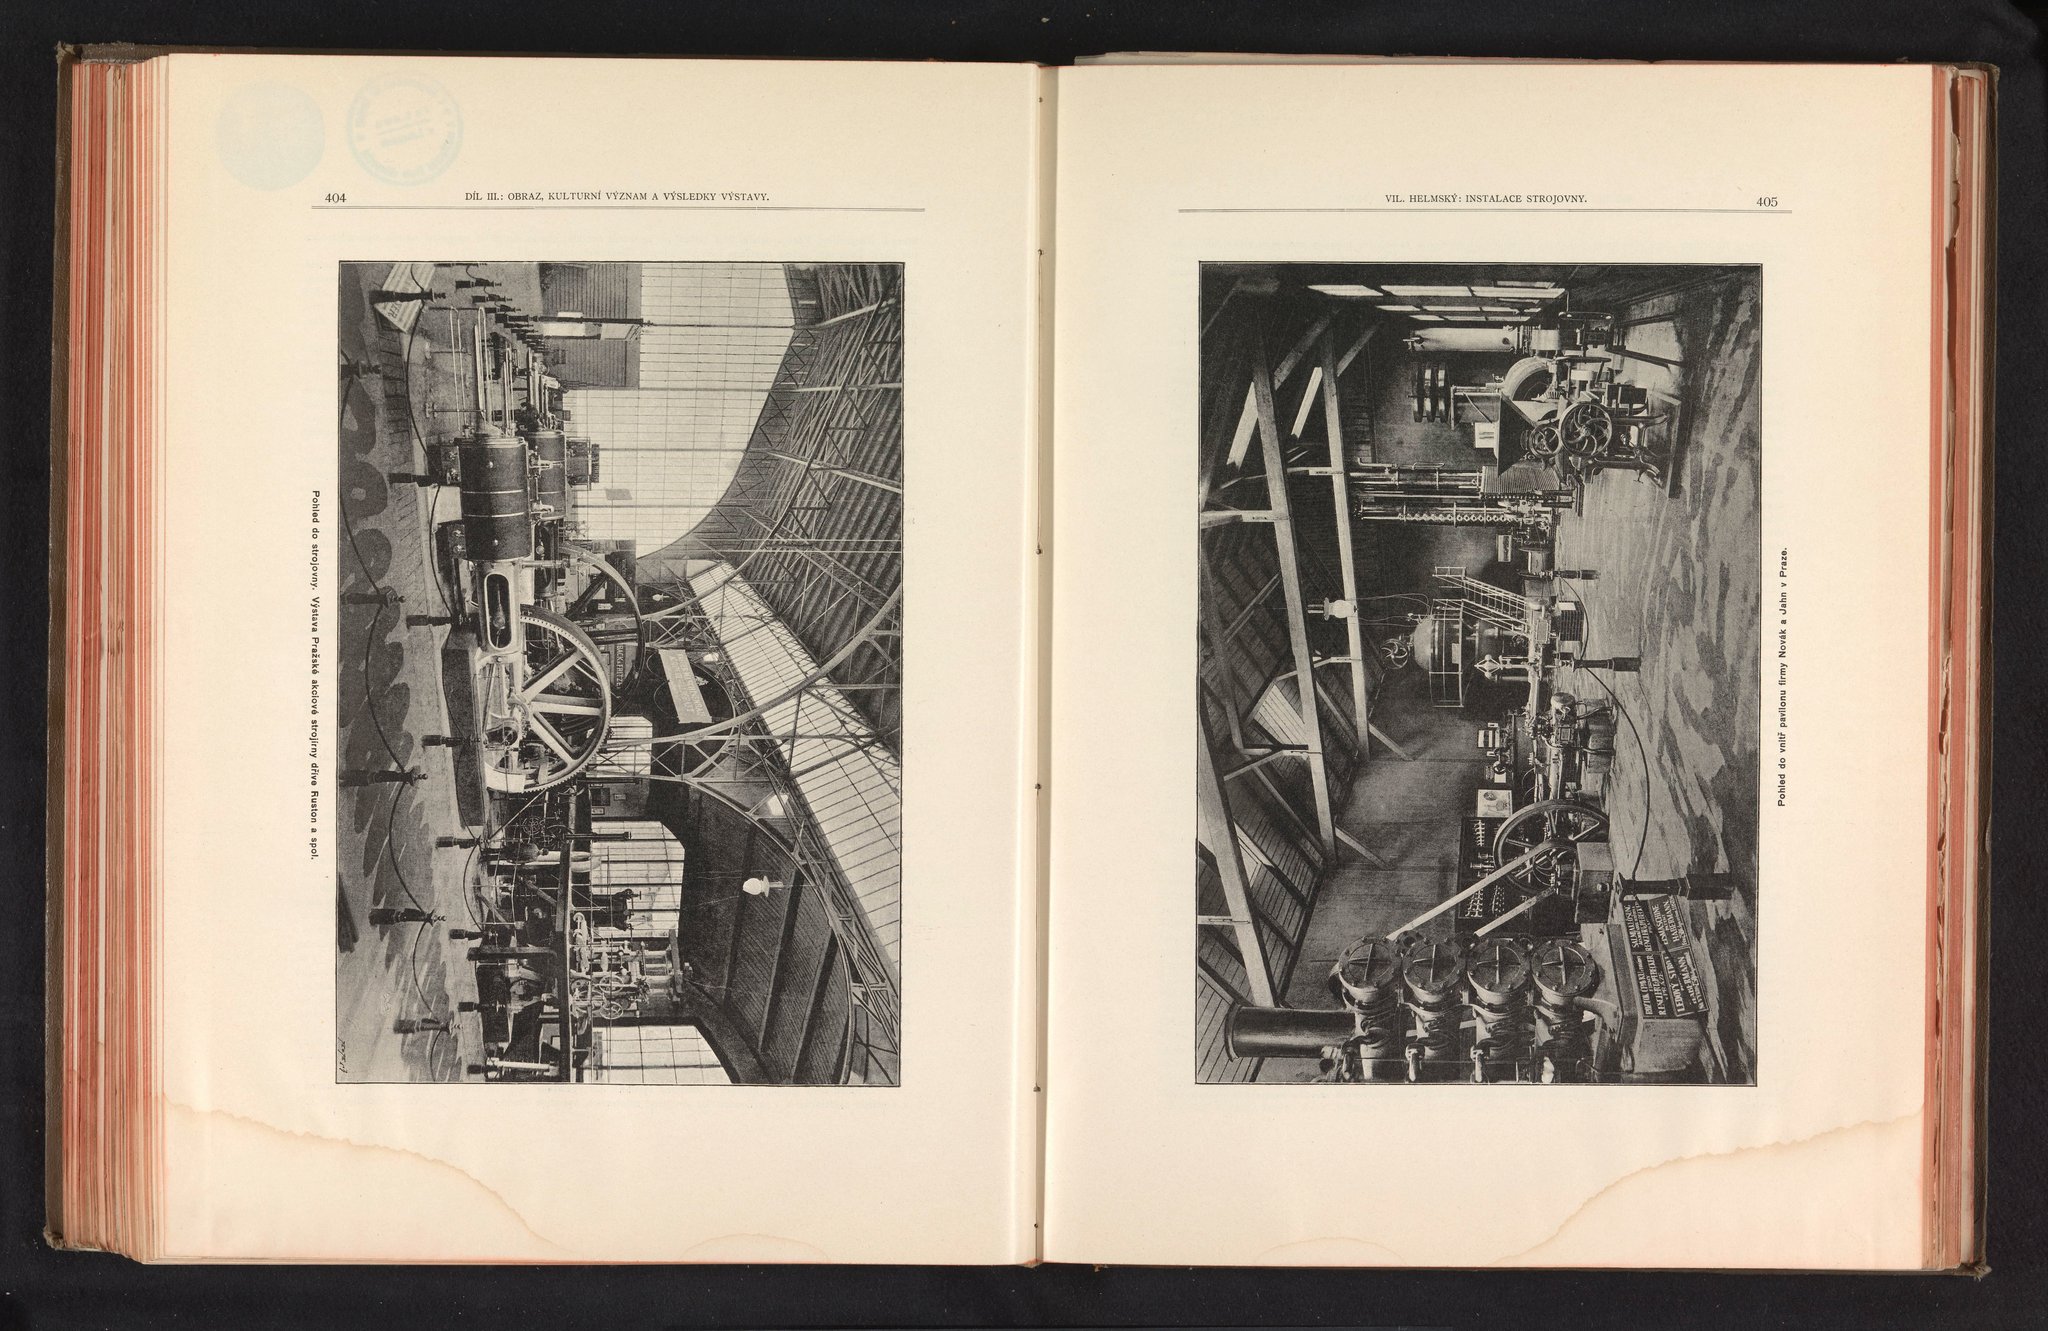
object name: photomechanical print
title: Pohled do vnitr pavilonu firmy Novak a Jahn v Praze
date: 1890-1895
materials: paper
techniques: autotype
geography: prague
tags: machines; parts of machines; tools and appliances, interior ~ representation of a building